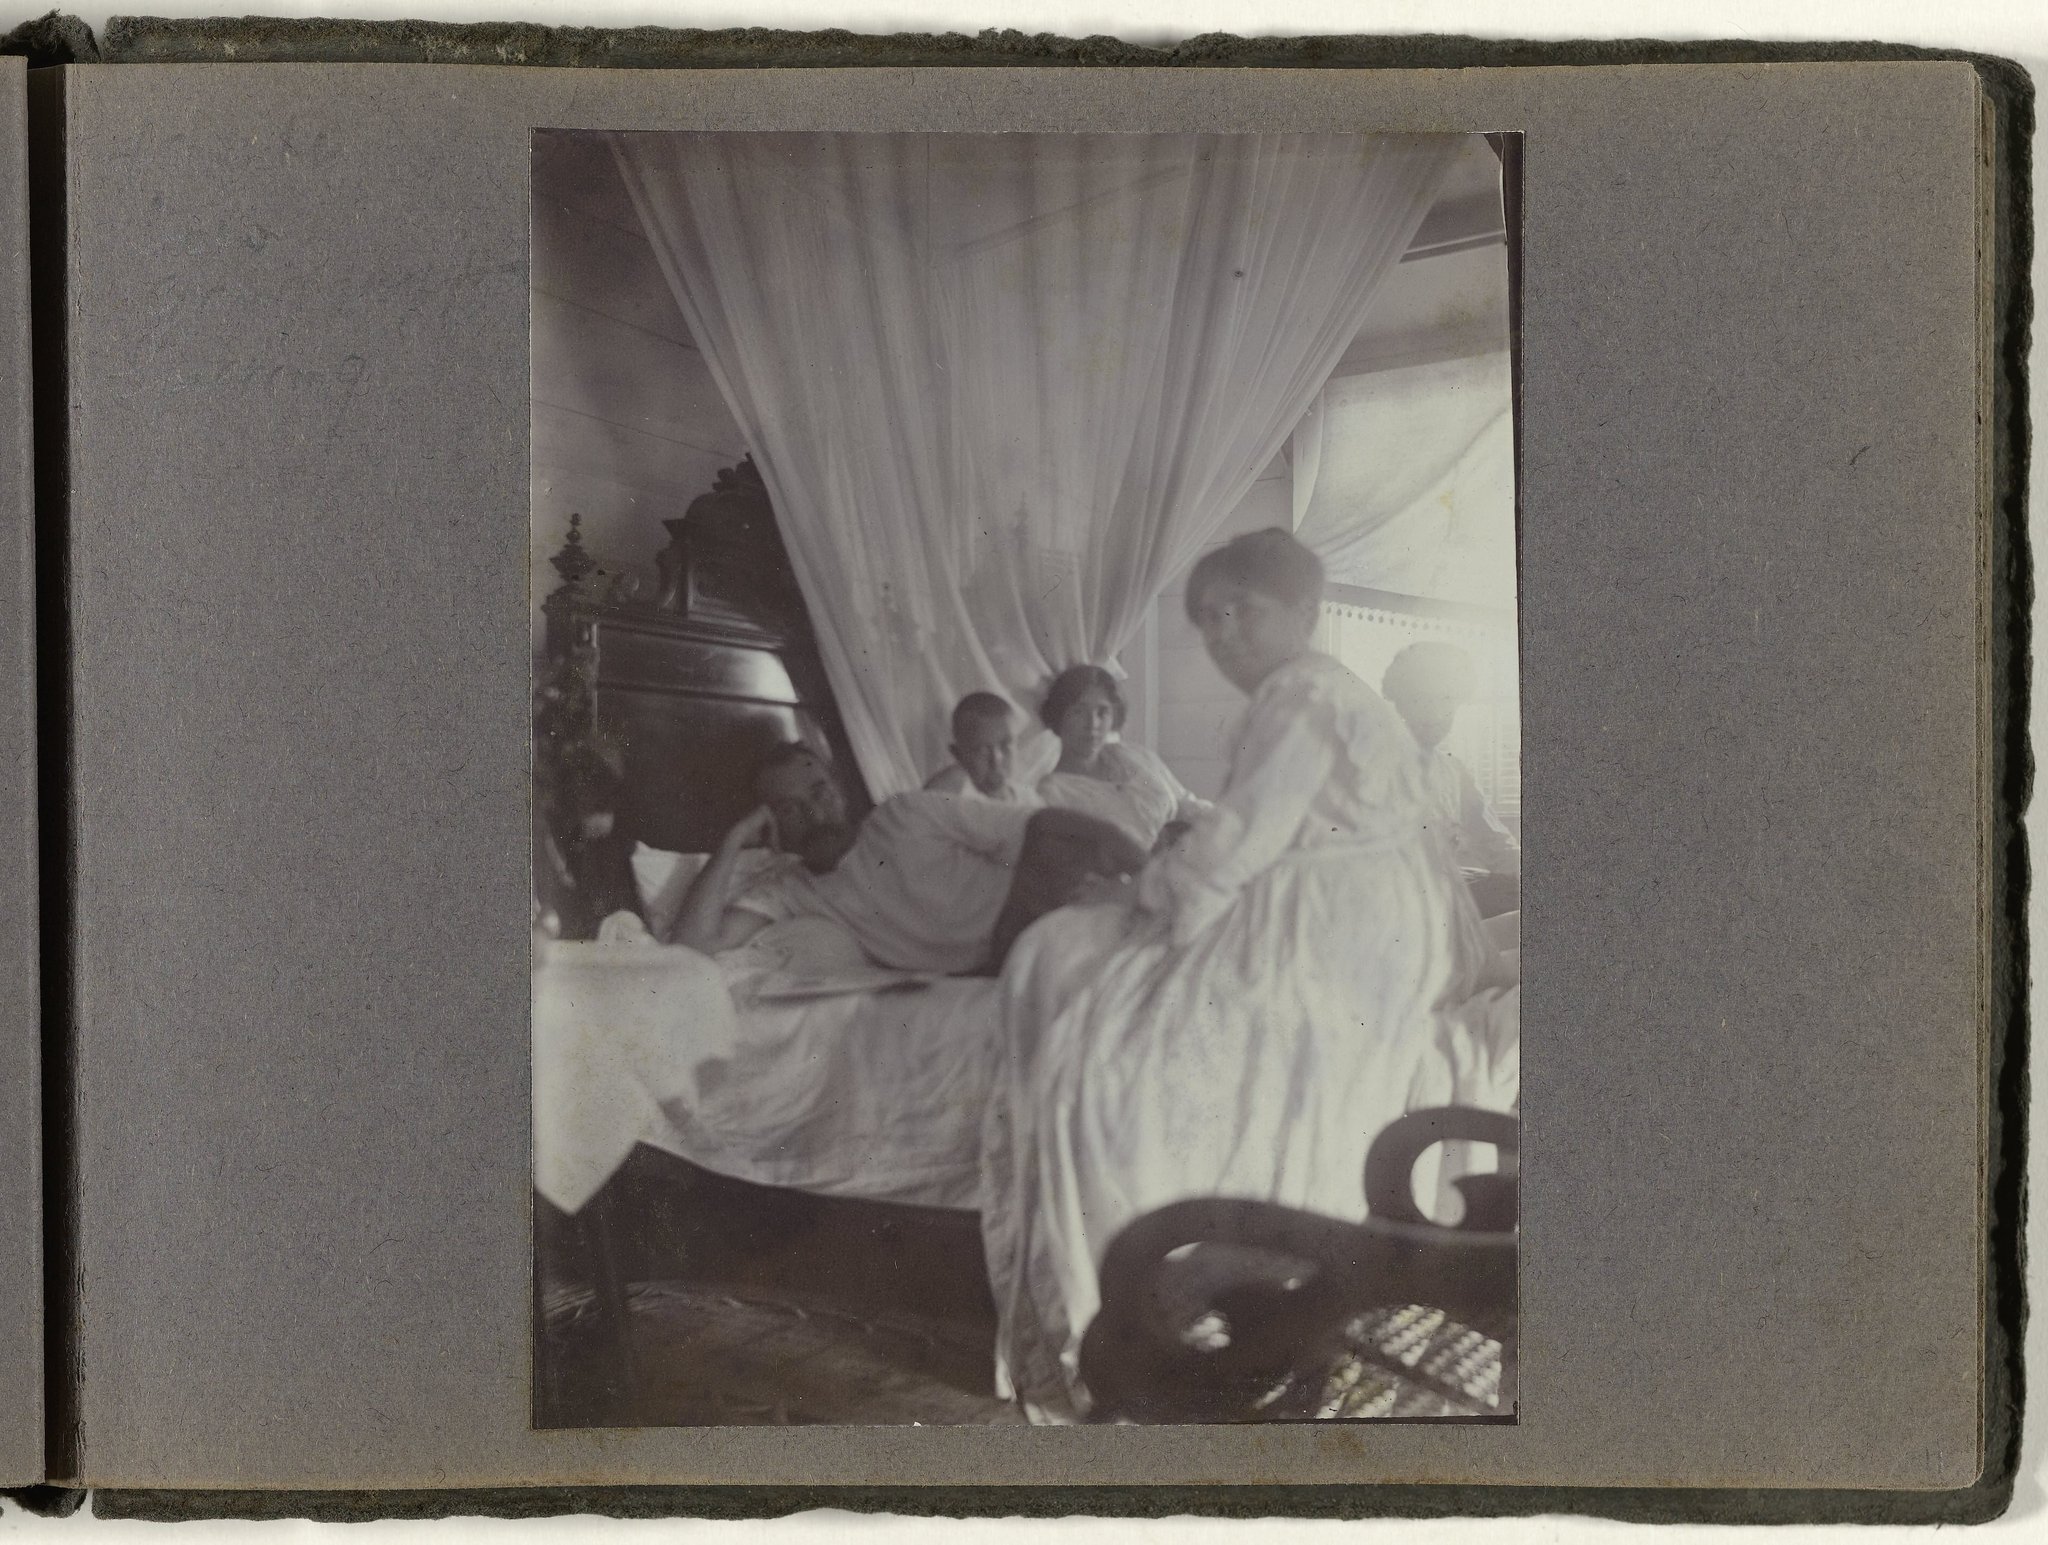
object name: photograph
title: Familie op bed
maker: Anonymous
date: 1910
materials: photographic support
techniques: gelatin silver print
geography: suriname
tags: plantation, suriname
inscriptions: inscription: ‘tante Loes Gonggrijp Spiering’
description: Enkele leden van de familie Gonggrijp zittend op een bed. Het betreffen Stephanus Hendrik Gonggrijp en Louise Catharina Spiering van plantage Morgenstond met hun kinderen Hans en Anna Barbara (Annie) Gonggrijp. De foto is waarschijnlijk genomen in het huis van Jacob Isaac Spiering aan de Gravenstraat (tegenwoordig Henck Arronstraat) tegenover het Bisschopshuis in Paramaribo. De vrouw rechts op de achtergrond is mogelijk Ninne (=nanny) Atta, de dienstbode op Morgenstond.